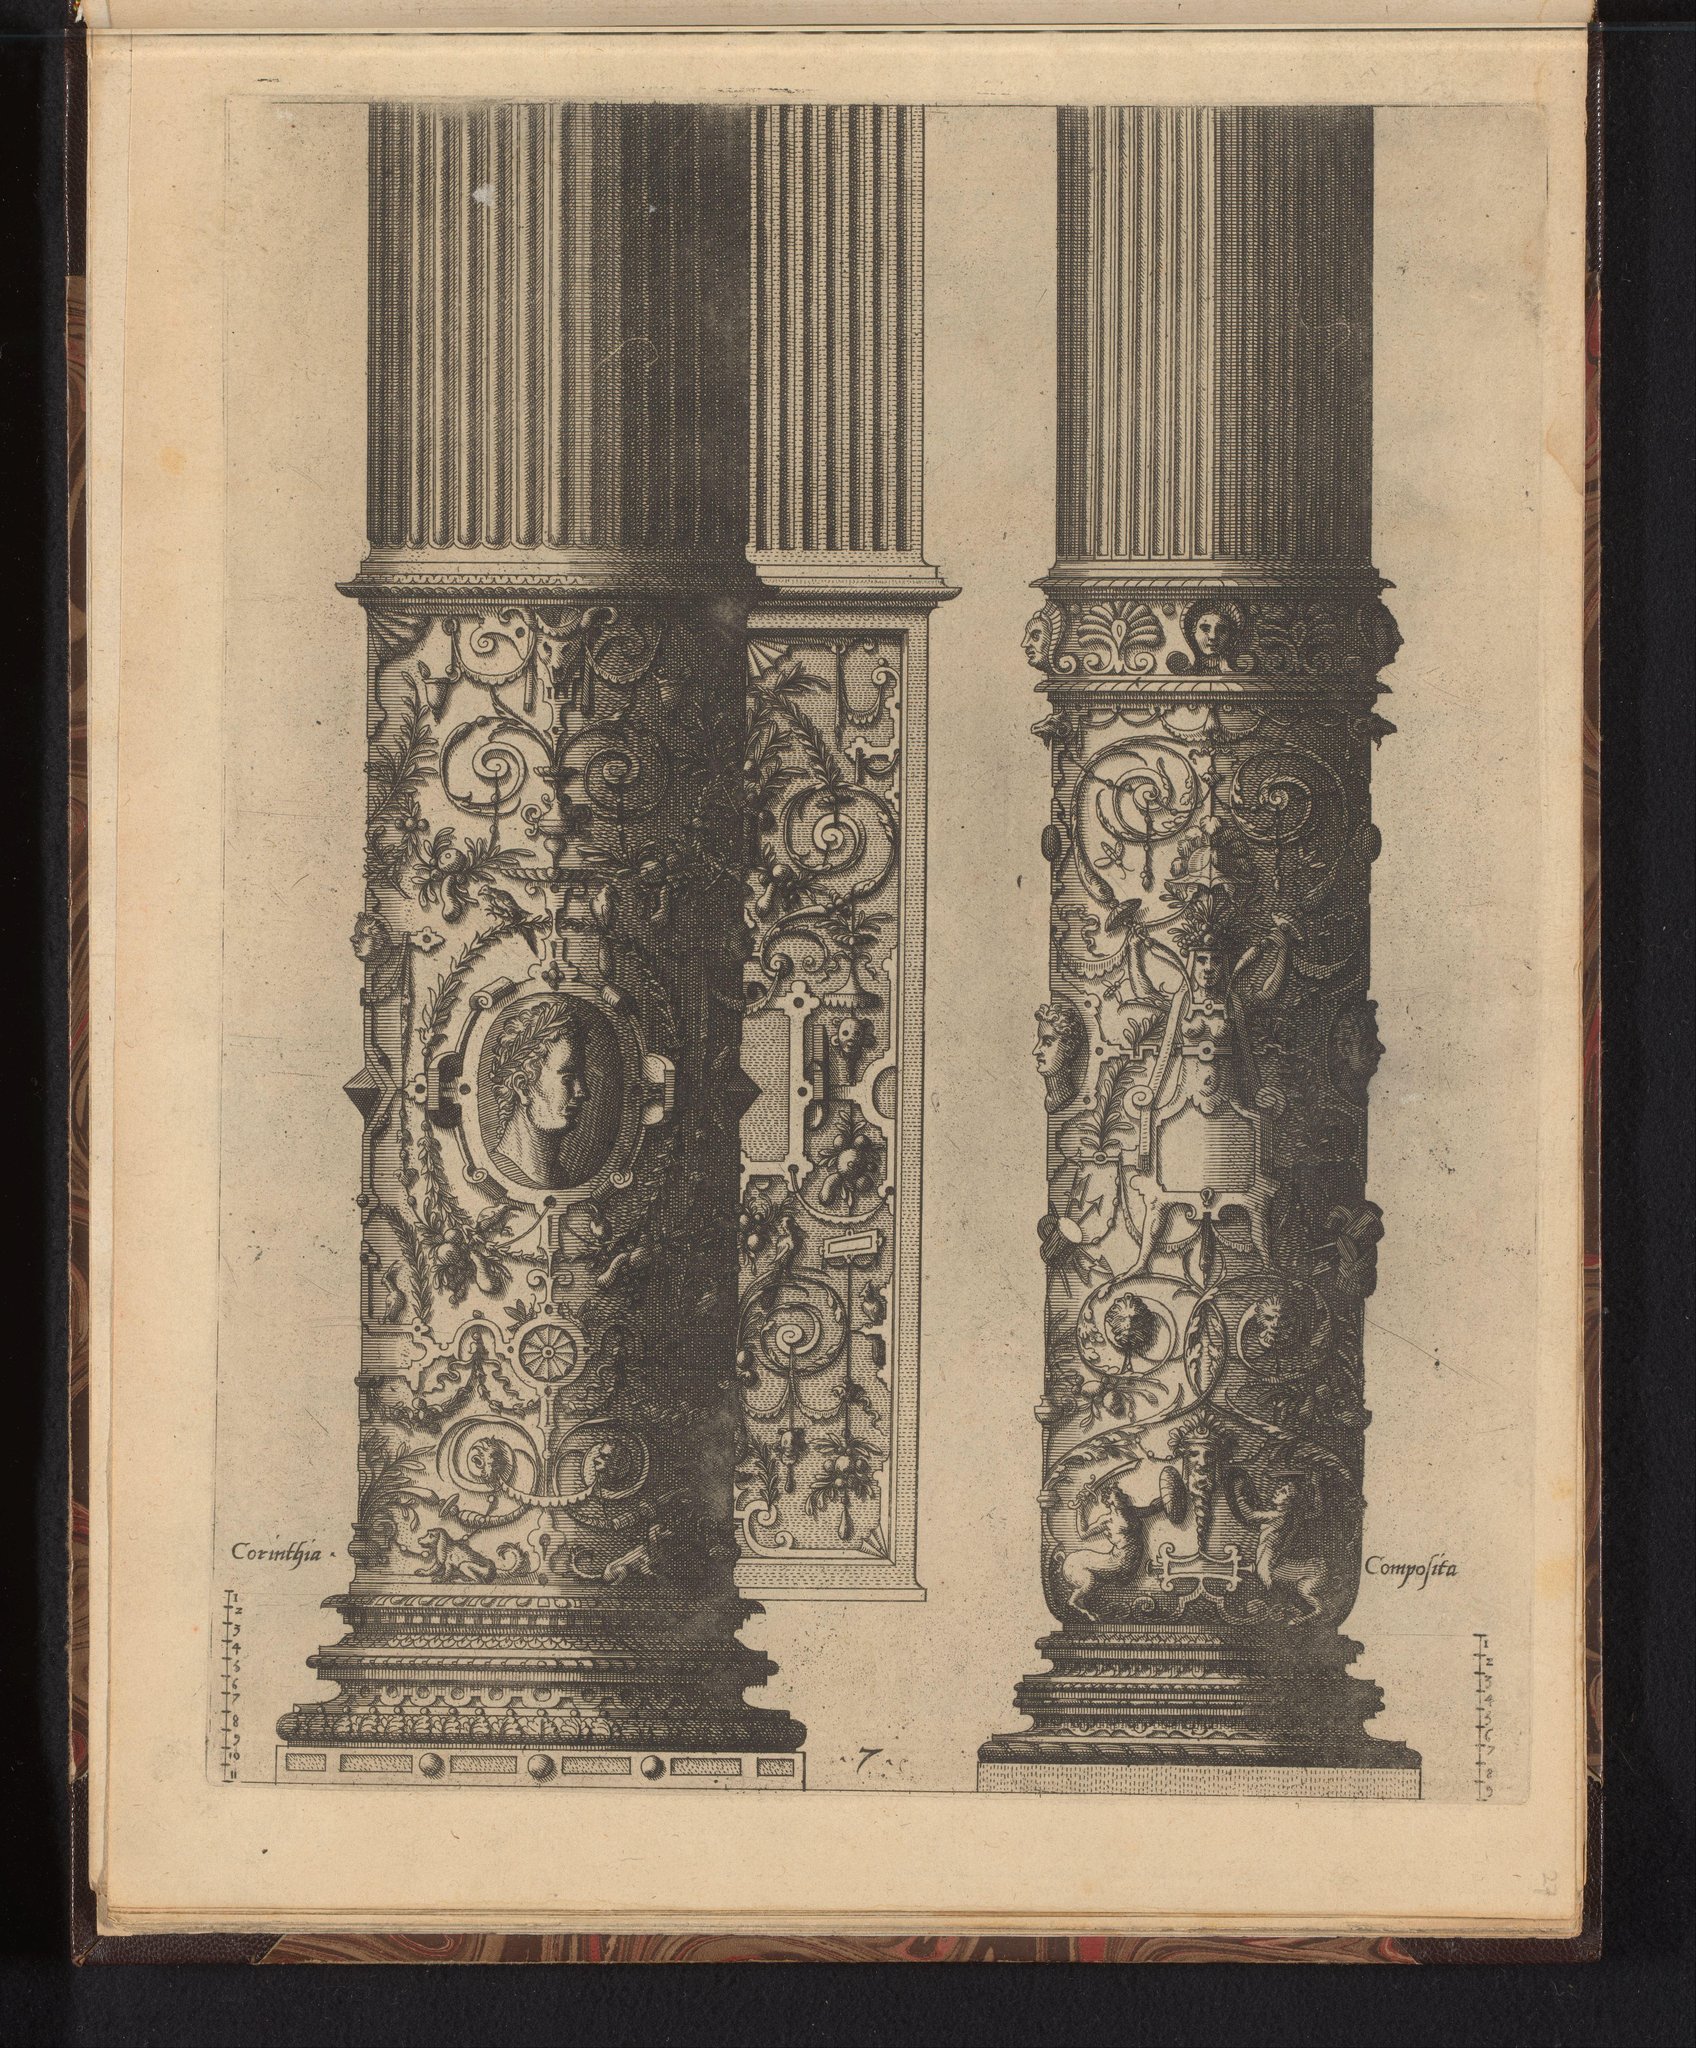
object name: ornament print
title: Twee 'columnae caelatae', in de Korinthische en Composiete Orde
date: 1565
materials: paper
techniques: etching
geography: antwerp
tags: composite order ~ architecture, column, pillar ~ architecture, corinthian order ~ architecture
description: Twee 'columnae caelatae in de Korintische en Composiete Orde, gedecoreerd met grotesken, guirlandes en bladranken. Op de linker zuil bevindt zich in het midden een ovaal met een bekranst mannenhoofd. Op de rechter zuil zit een vrouwelijke figuur gevangen in beslagwerk. Onderaan twee centauren. Achter de linker zuil is een deel van een gecanneleerde pilaster zichtbaar. Op de prent is twee maal een schaalverdeling aangegeven. De prent maakt deel uit van een album.